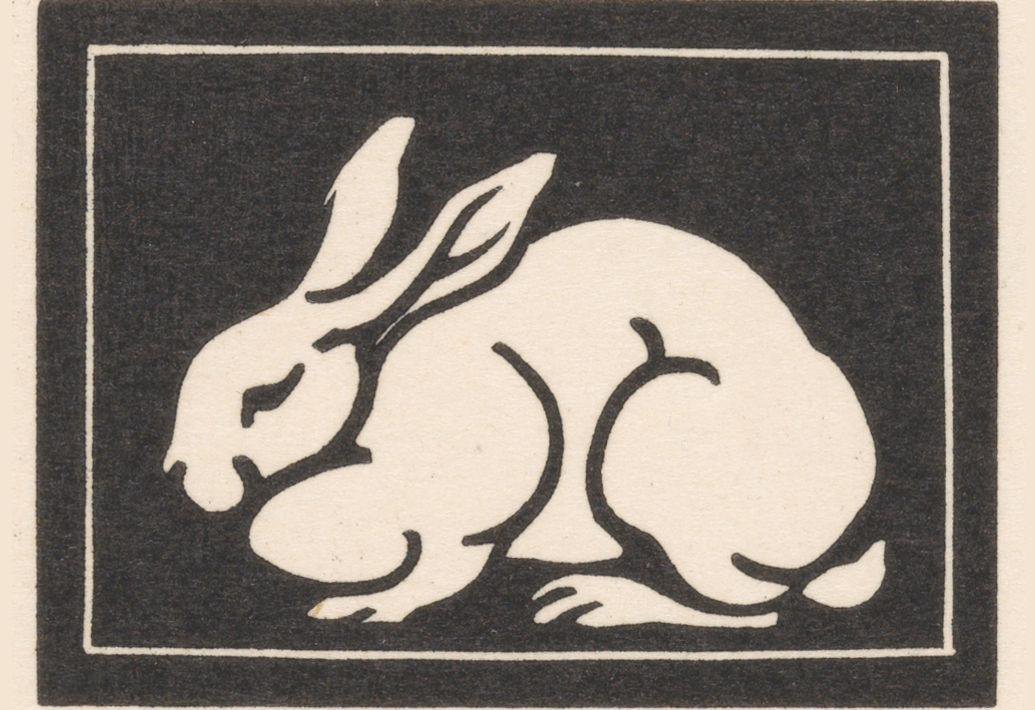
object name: print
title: Konijn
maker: julie de graag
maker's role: draughtsman, print maker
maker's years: 1877-1924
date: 1923-1924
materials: paper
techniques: woodcut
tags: rodents: rabbit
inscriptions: collector's mark: Lugt 2228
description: Prent op een onversneden blad met zes andere prenten van dieren.